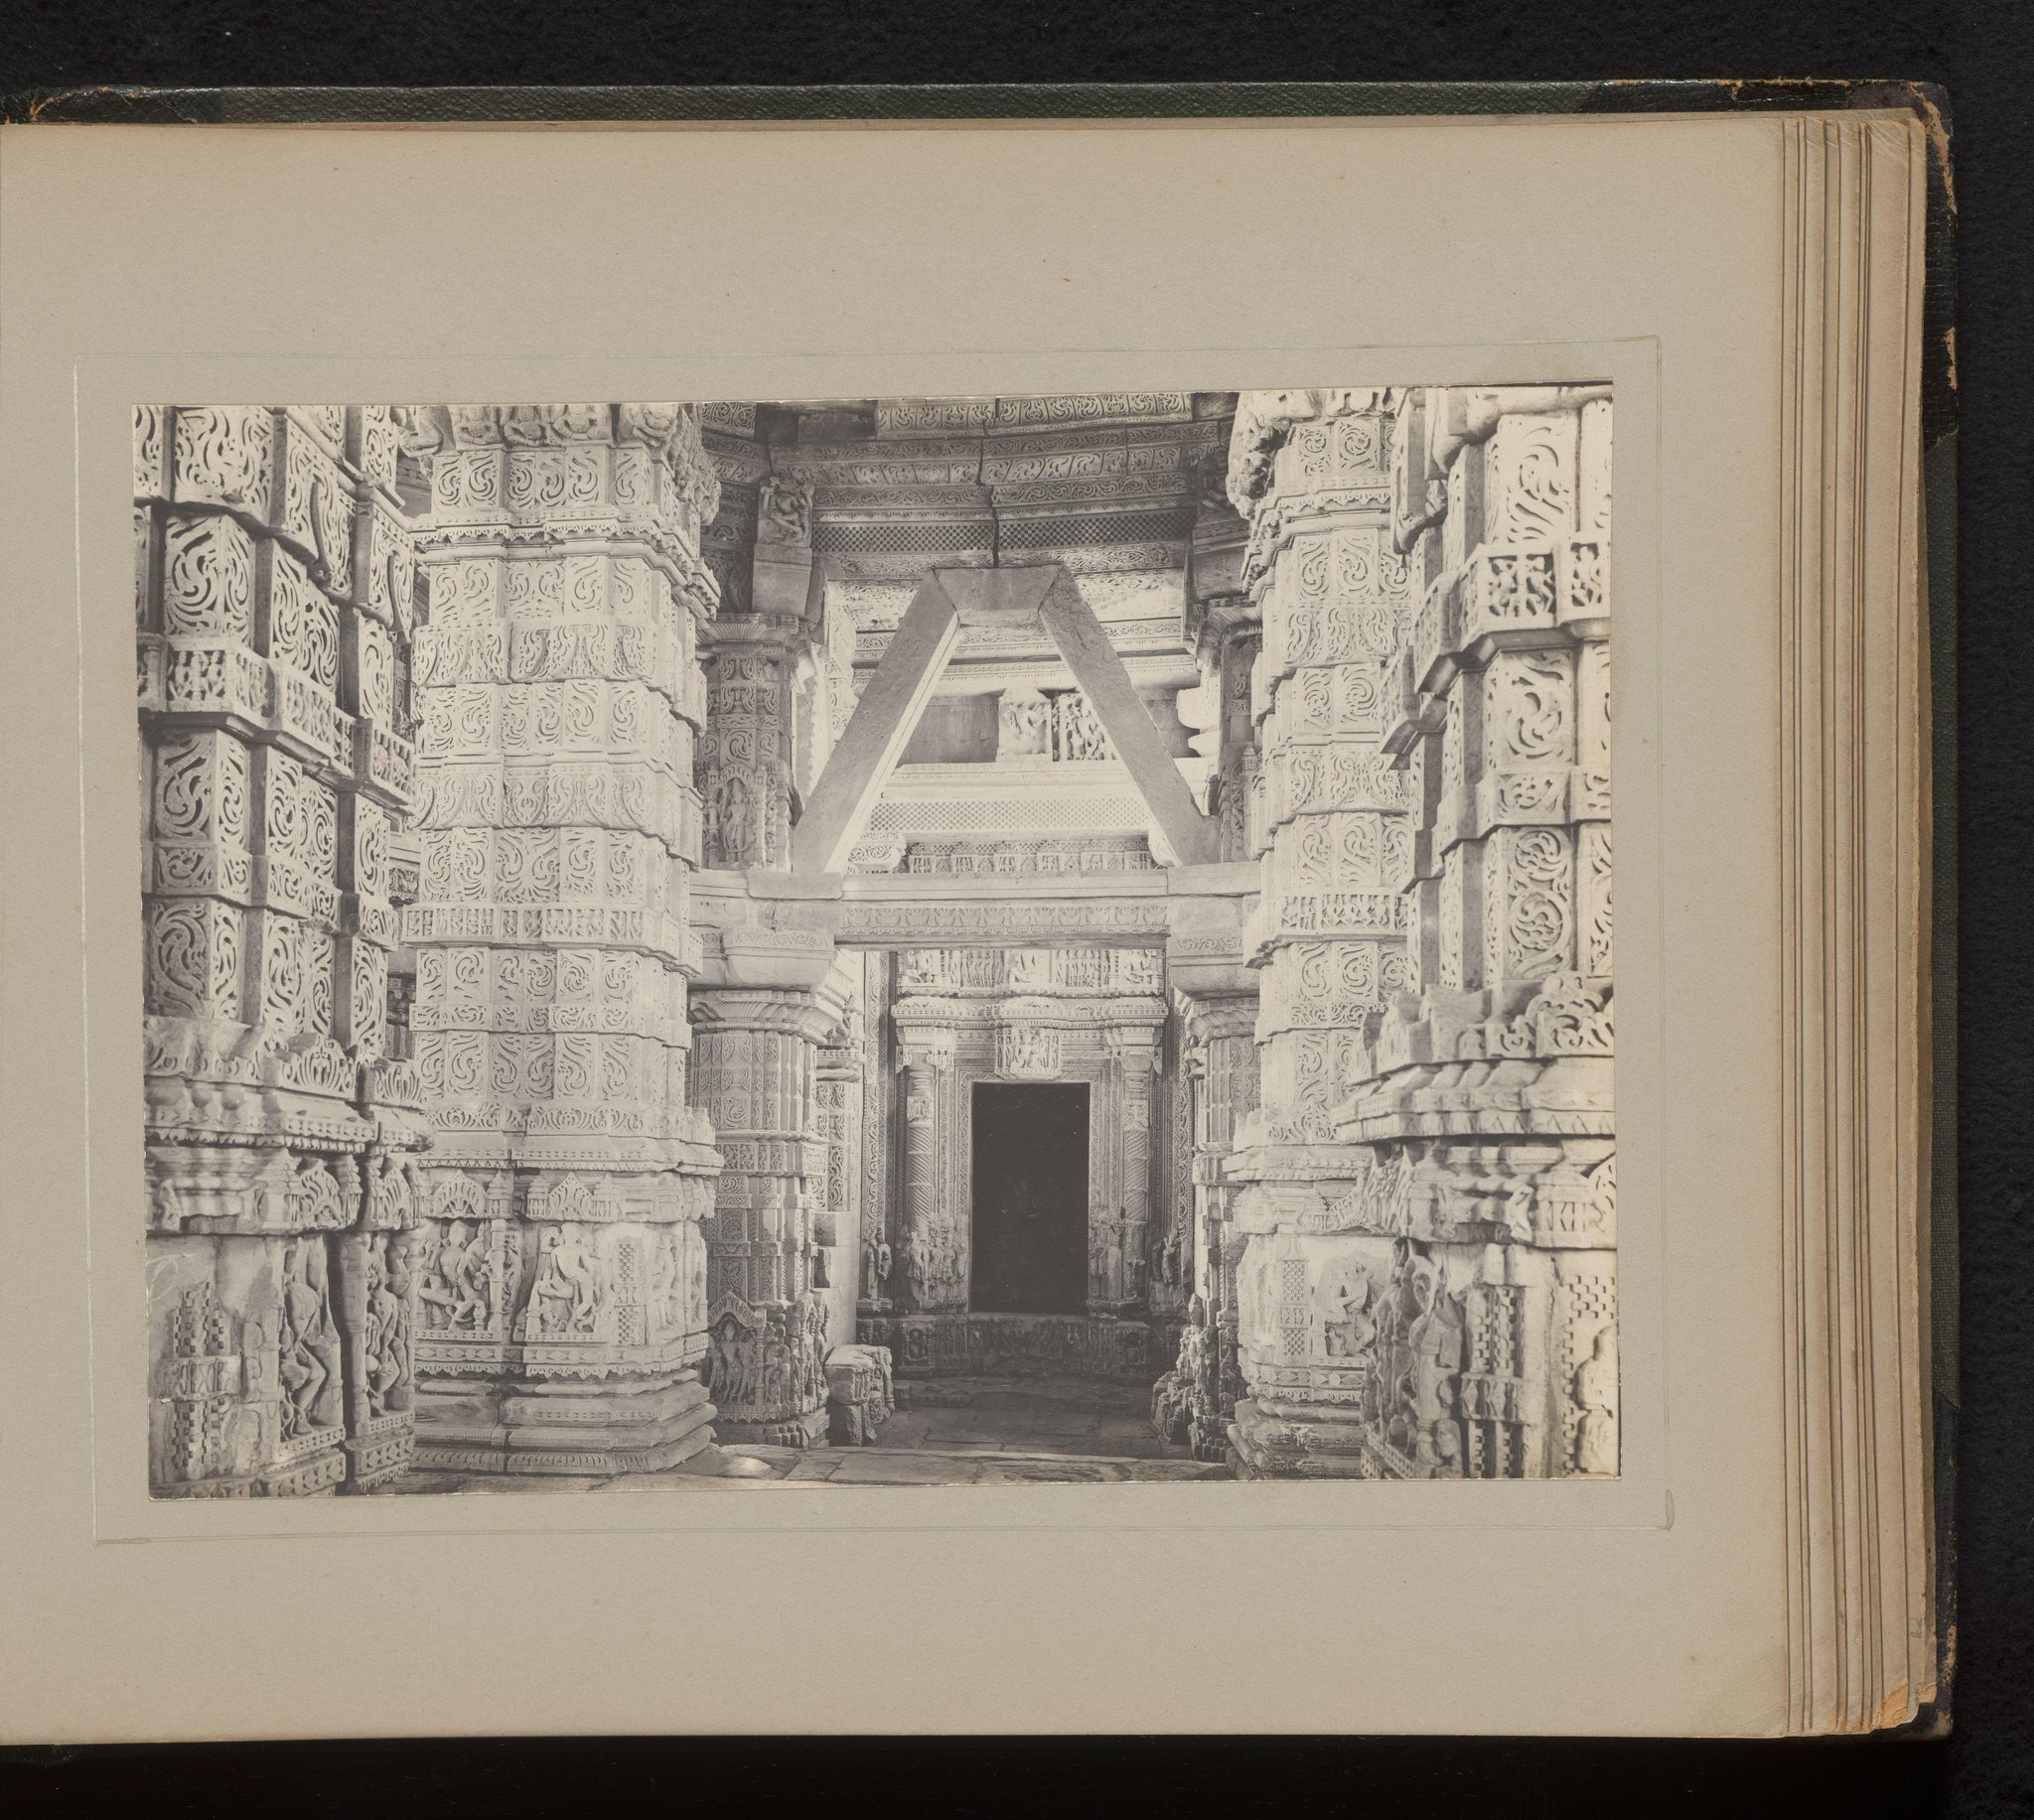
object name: page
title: Gedecoreerde zuilen bij de grote Sasbahu Tempel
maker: k.h. mawal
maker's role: fotograaf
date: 1900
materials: photographic support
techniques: gelatin silver print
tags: temple, shrine ~ hinduism, buddhism, jainism, column, pillar ~ architecture